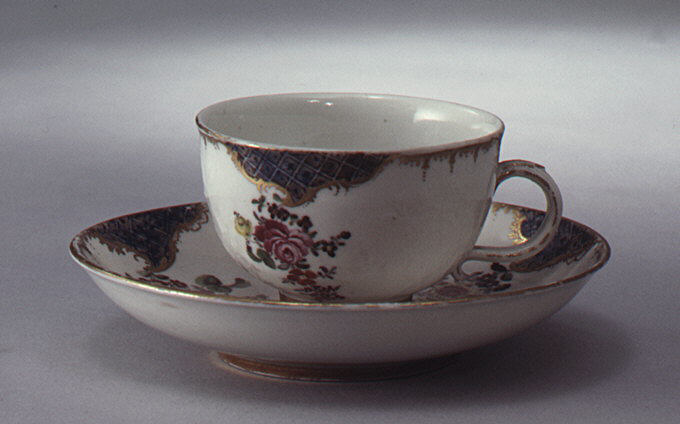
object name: cup and saucer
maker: frankenthal porcelain manufactory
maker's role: manufactory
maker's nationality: german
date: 1755-1760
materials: hard paste porcelain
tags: roses